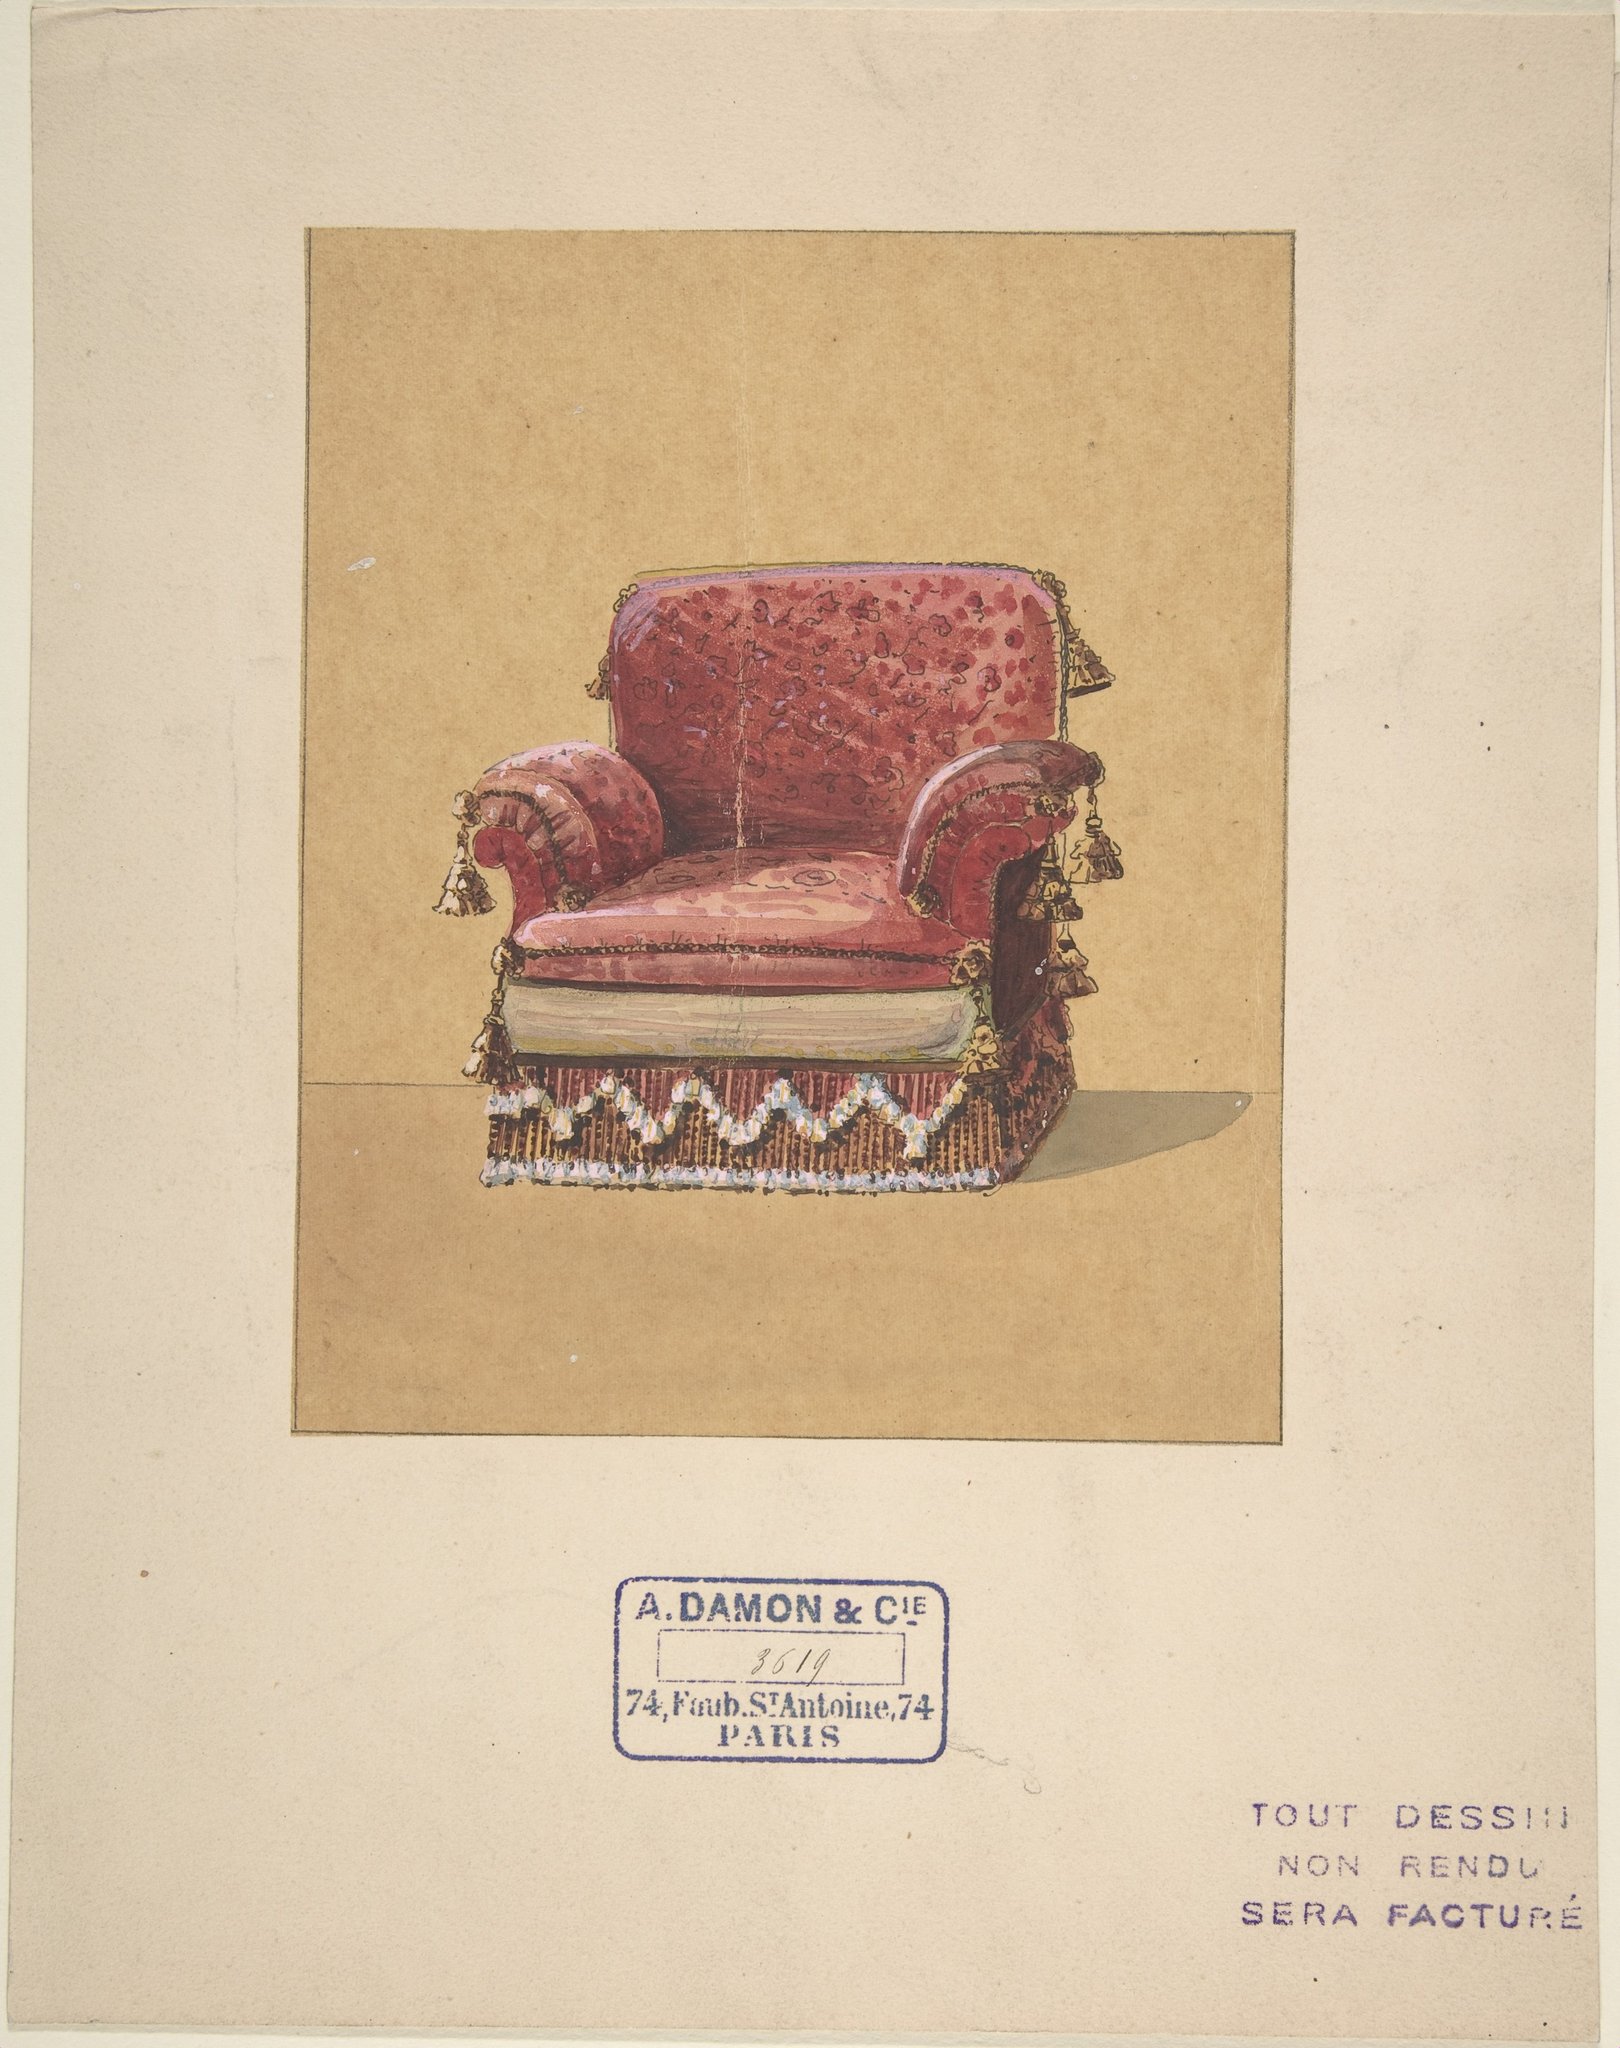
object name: drawing ornament architecture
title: Design for an Armchair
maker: a. damon et cie.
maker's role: artist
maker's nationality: french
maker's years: 1870-1900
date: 1801-1900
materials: gouache, graphite, ink, watercolor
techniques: pen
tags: chairs